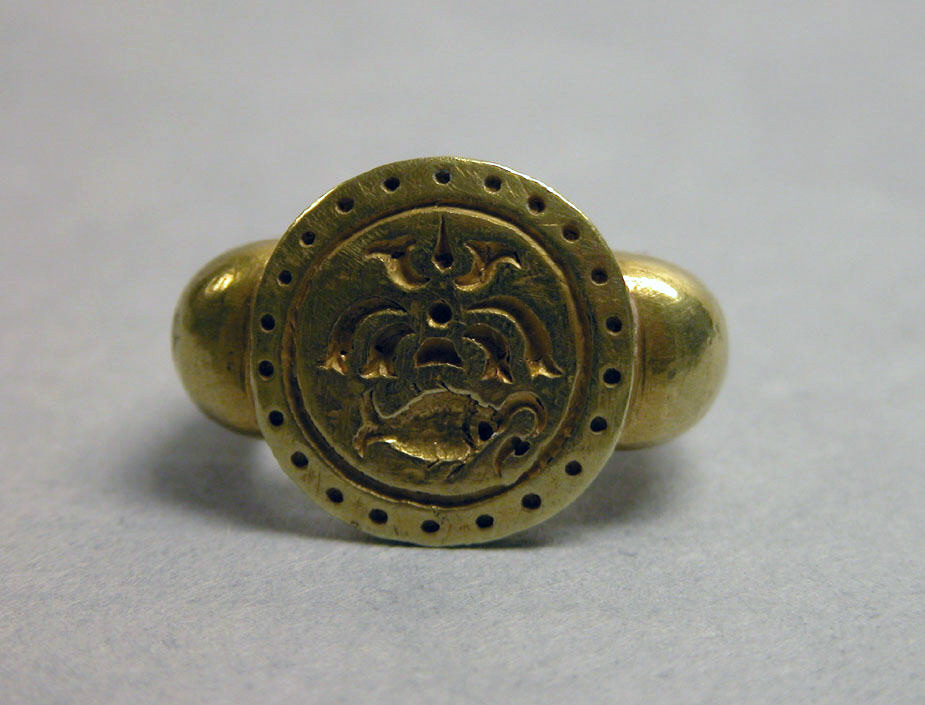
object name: ring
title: Ring with Circular Bezel with Inscribed Fish Motif and "Sri"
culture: indonesian, javanese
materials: gold